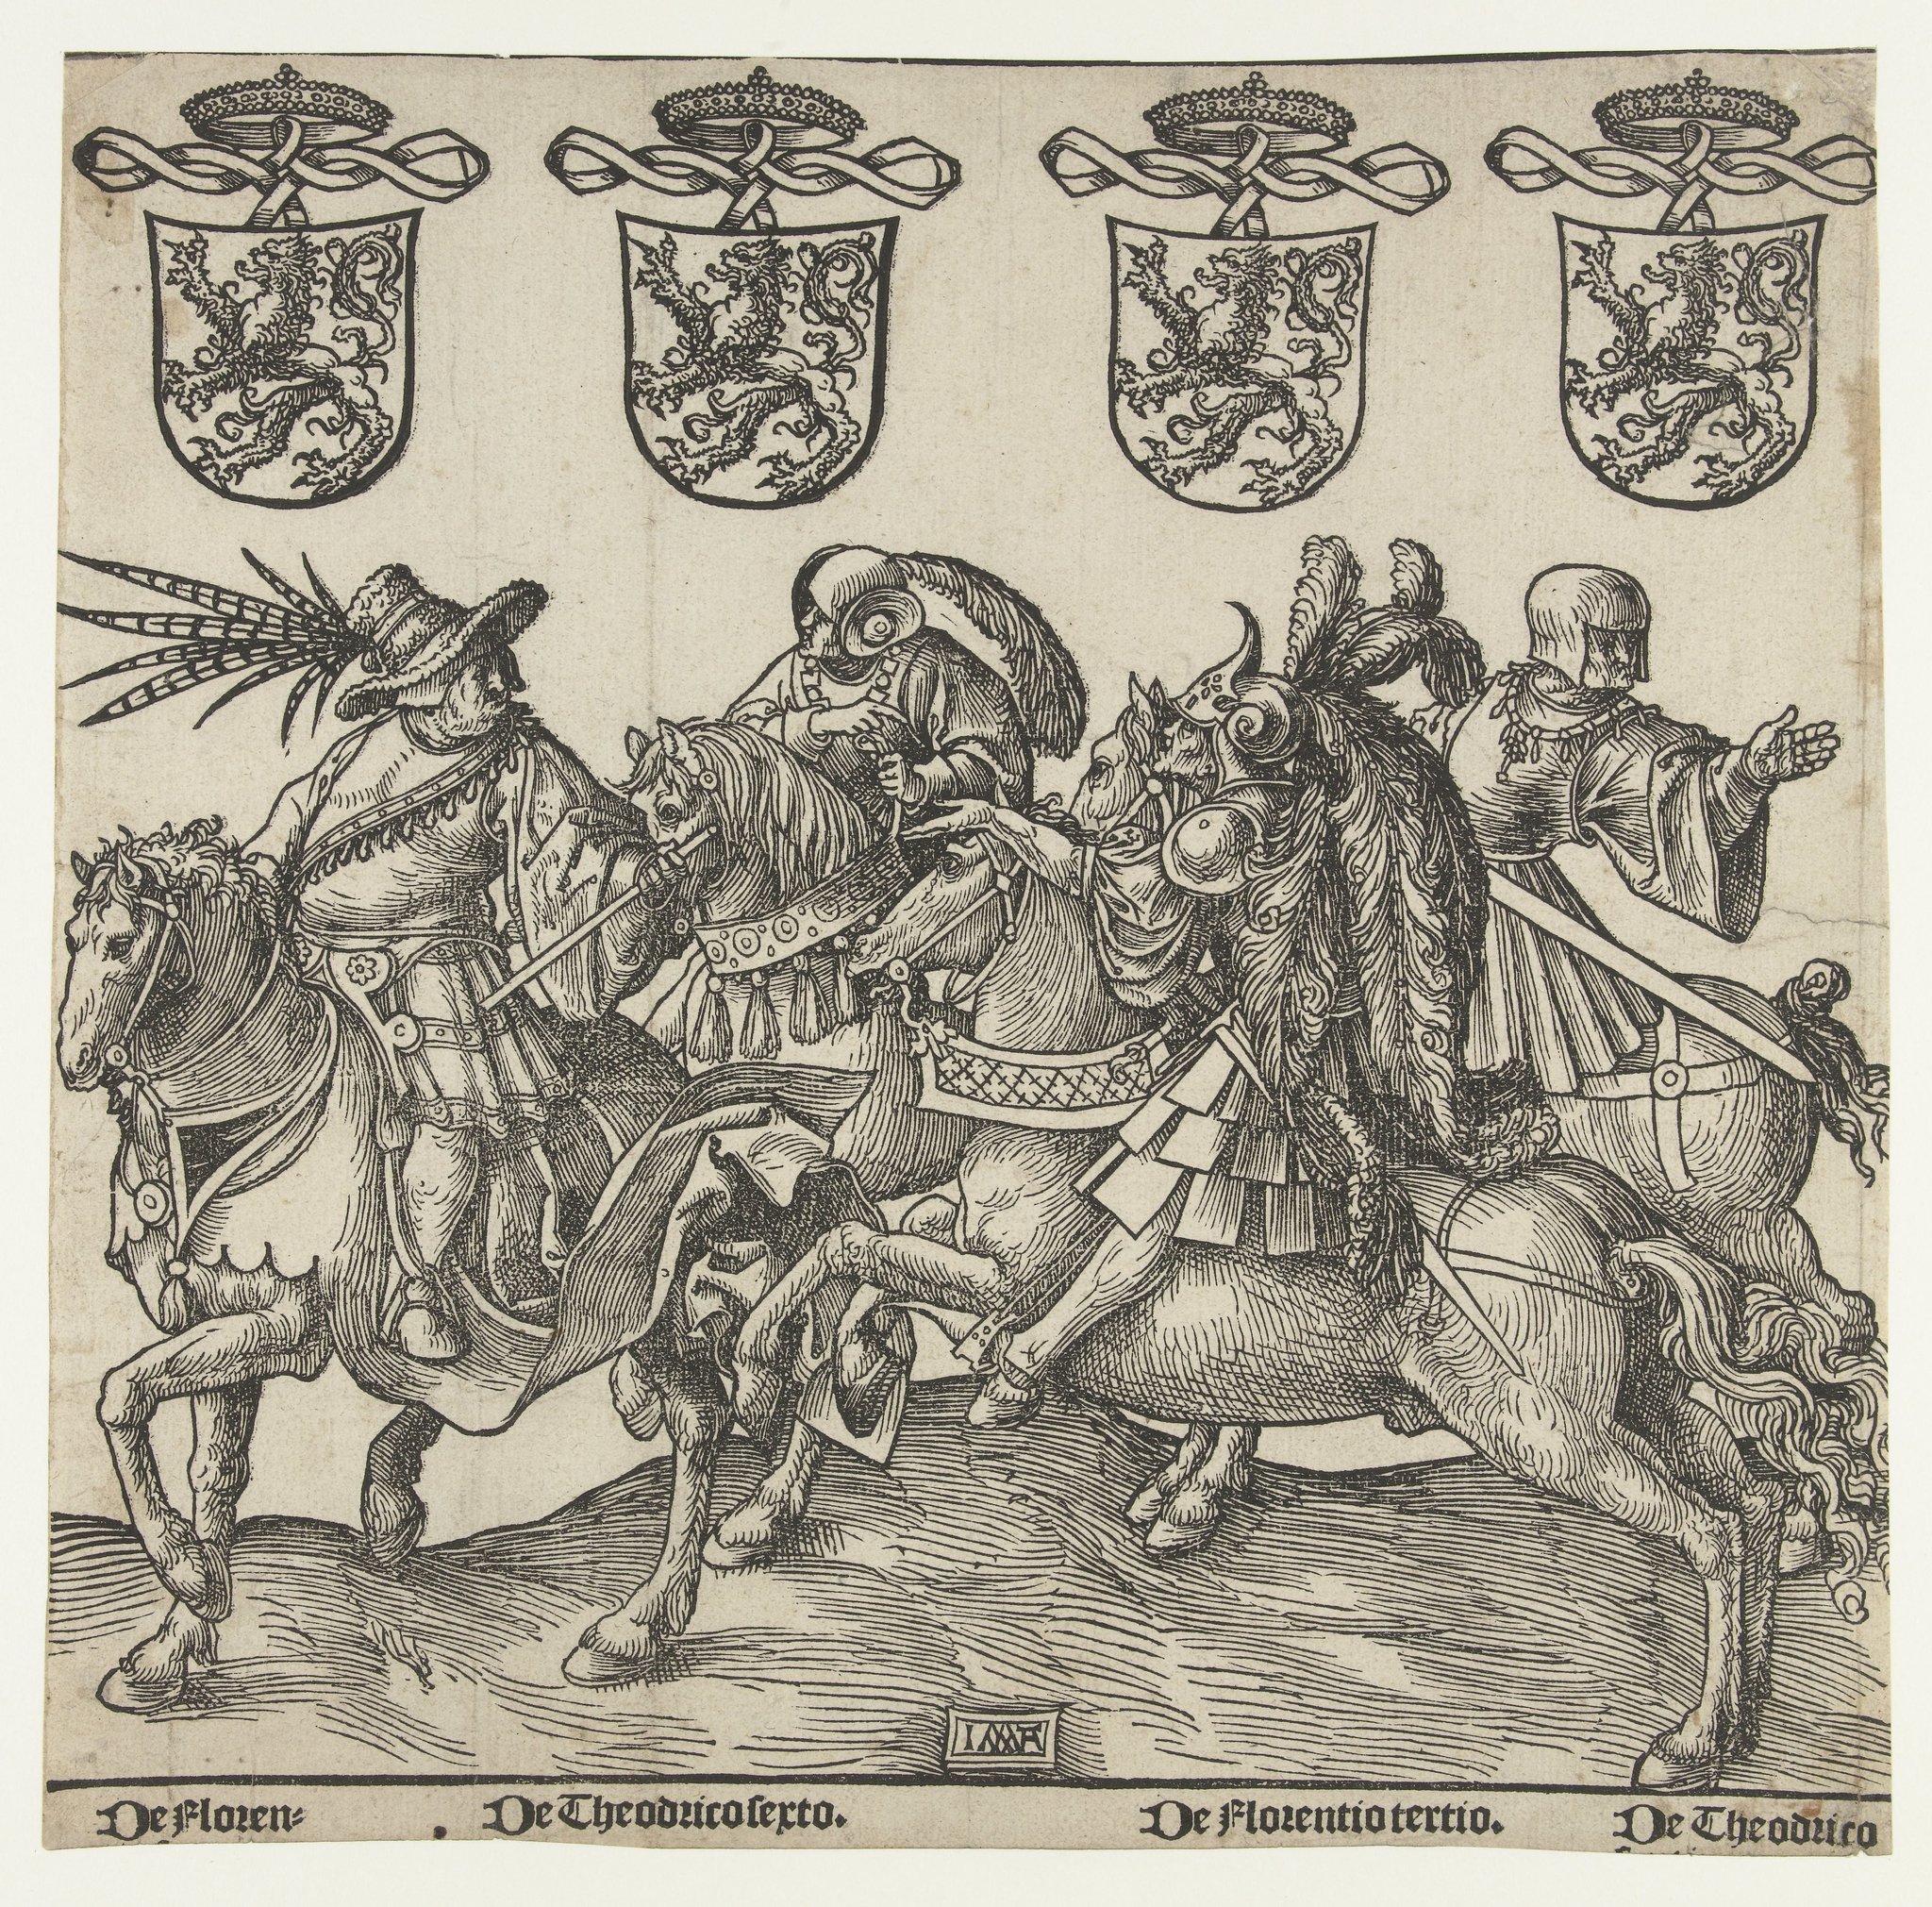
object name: print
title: De Graven en Gravinnen van Holland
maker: jacob cornelisz van oostsanen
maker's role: draughtsman, painter, print maker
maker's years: 1475-1533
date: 1518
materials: paper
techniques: woodcut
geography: low countries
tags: floris ii (count of holland), equestrian state-portrait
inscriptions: collector's mark: Lugt 240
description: Twee uitgaven van de serie zijn bekend: één met Franse teksten en een titelblad met de naam van de uitgever Doen Pietersz. in Amsterdam en de dagtekening 1.4.1518, en één met Latijnse teksten, waarvan het titelblad ontbreekt, op het laatste blad opgedragen aan Karel V. Fragmenten van de later versneden blokken werden opgenomen in de "Cronicke van Brabant", Antwerpen 1530, door Jan van Doesborch.